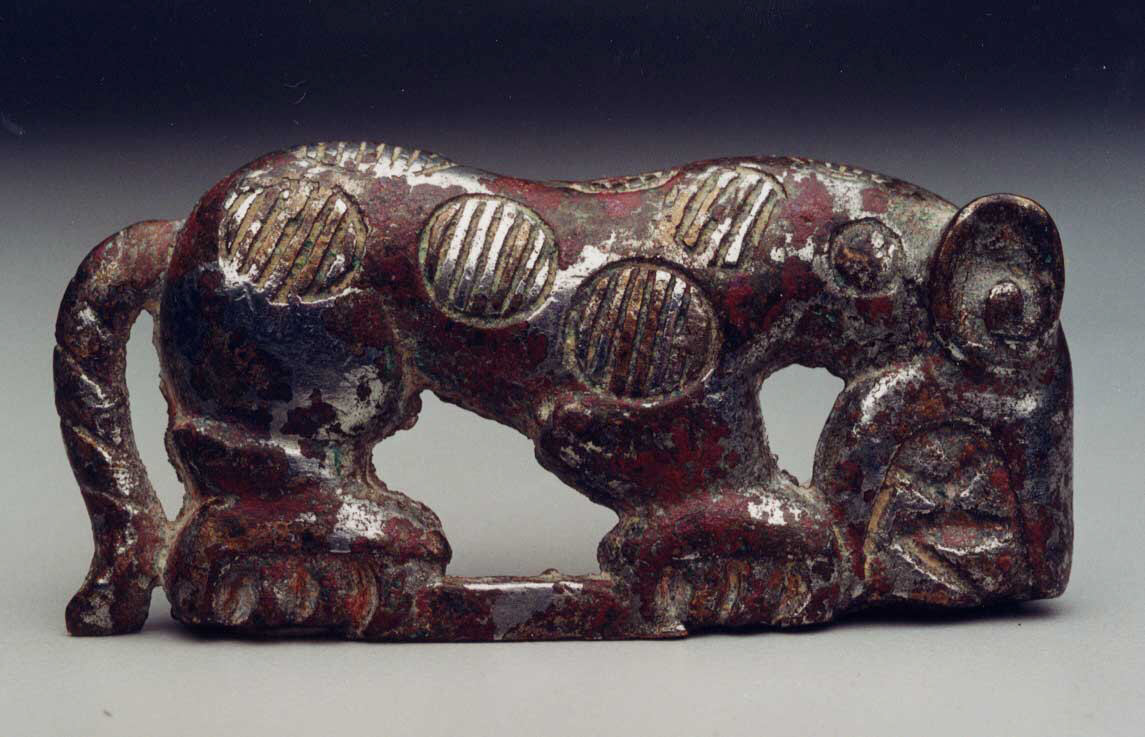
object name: garment plaque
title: Garment Plaque in the Shape of a Leopard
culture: northwest chinese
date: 500-401 BCE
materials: bronze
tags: leopards